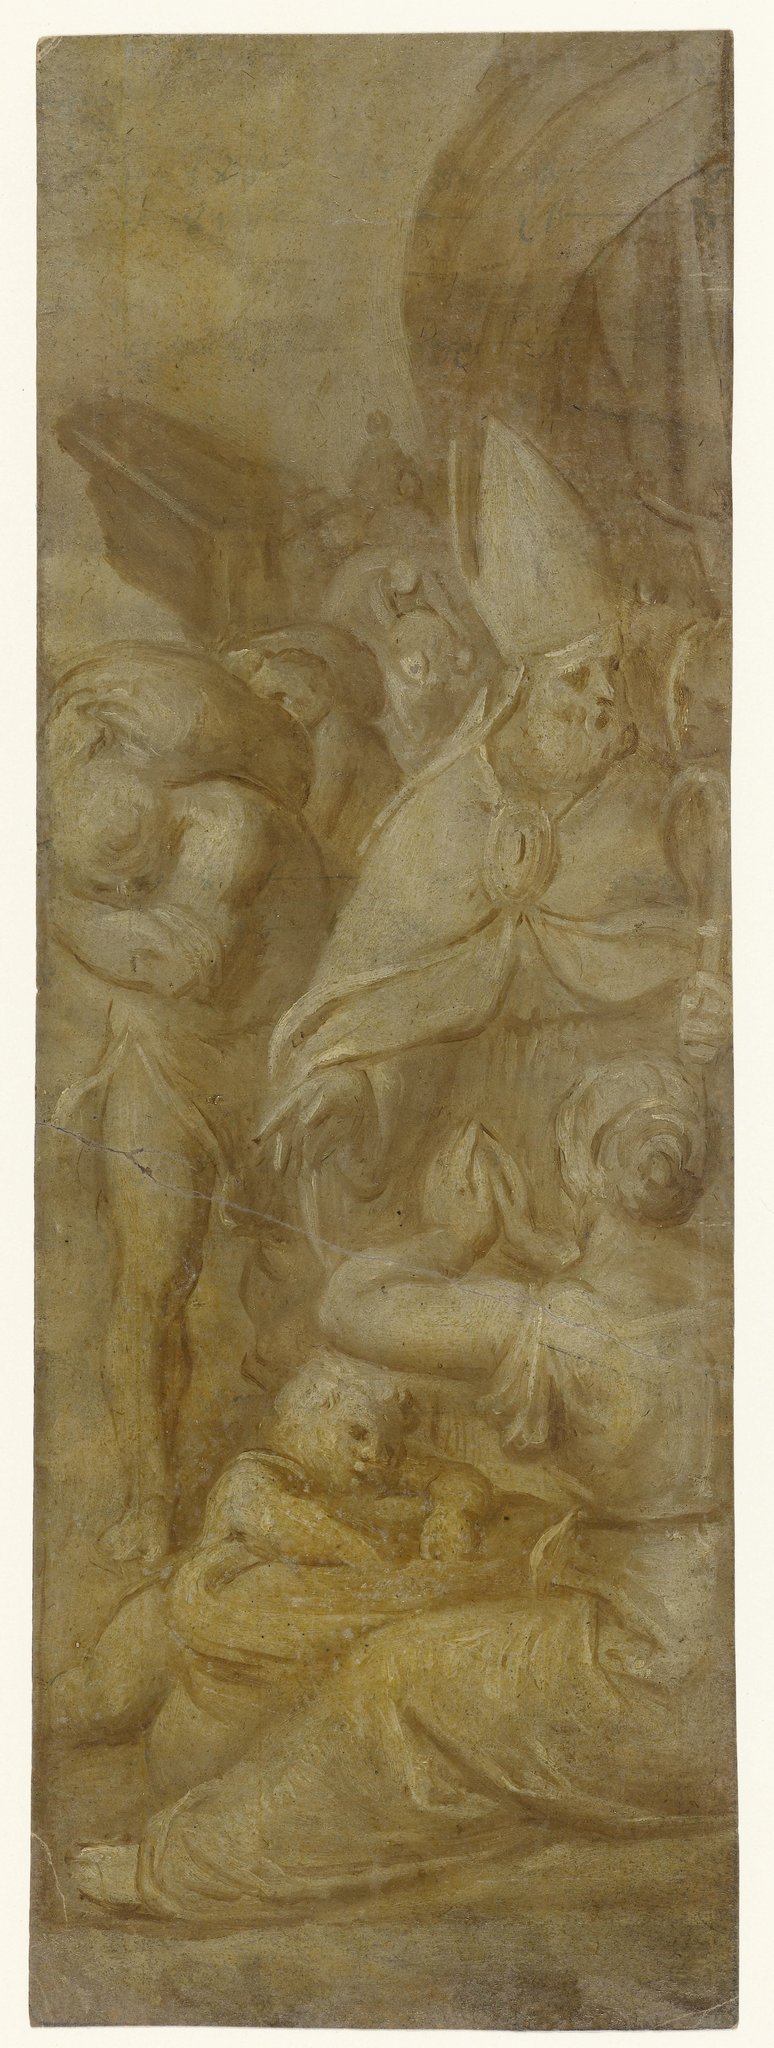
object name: design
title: Heilige Nicolaas redt de stad Myra van de hongersnood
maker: otto van veen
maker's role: draughtsman, painter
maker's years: 1556-1629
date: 1600-1610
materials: oil, paper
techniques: grisaille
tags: during a famine at myra, st. nicholas miraculously multiplies the number of corn-sacks, unloaded from boats in the harbour